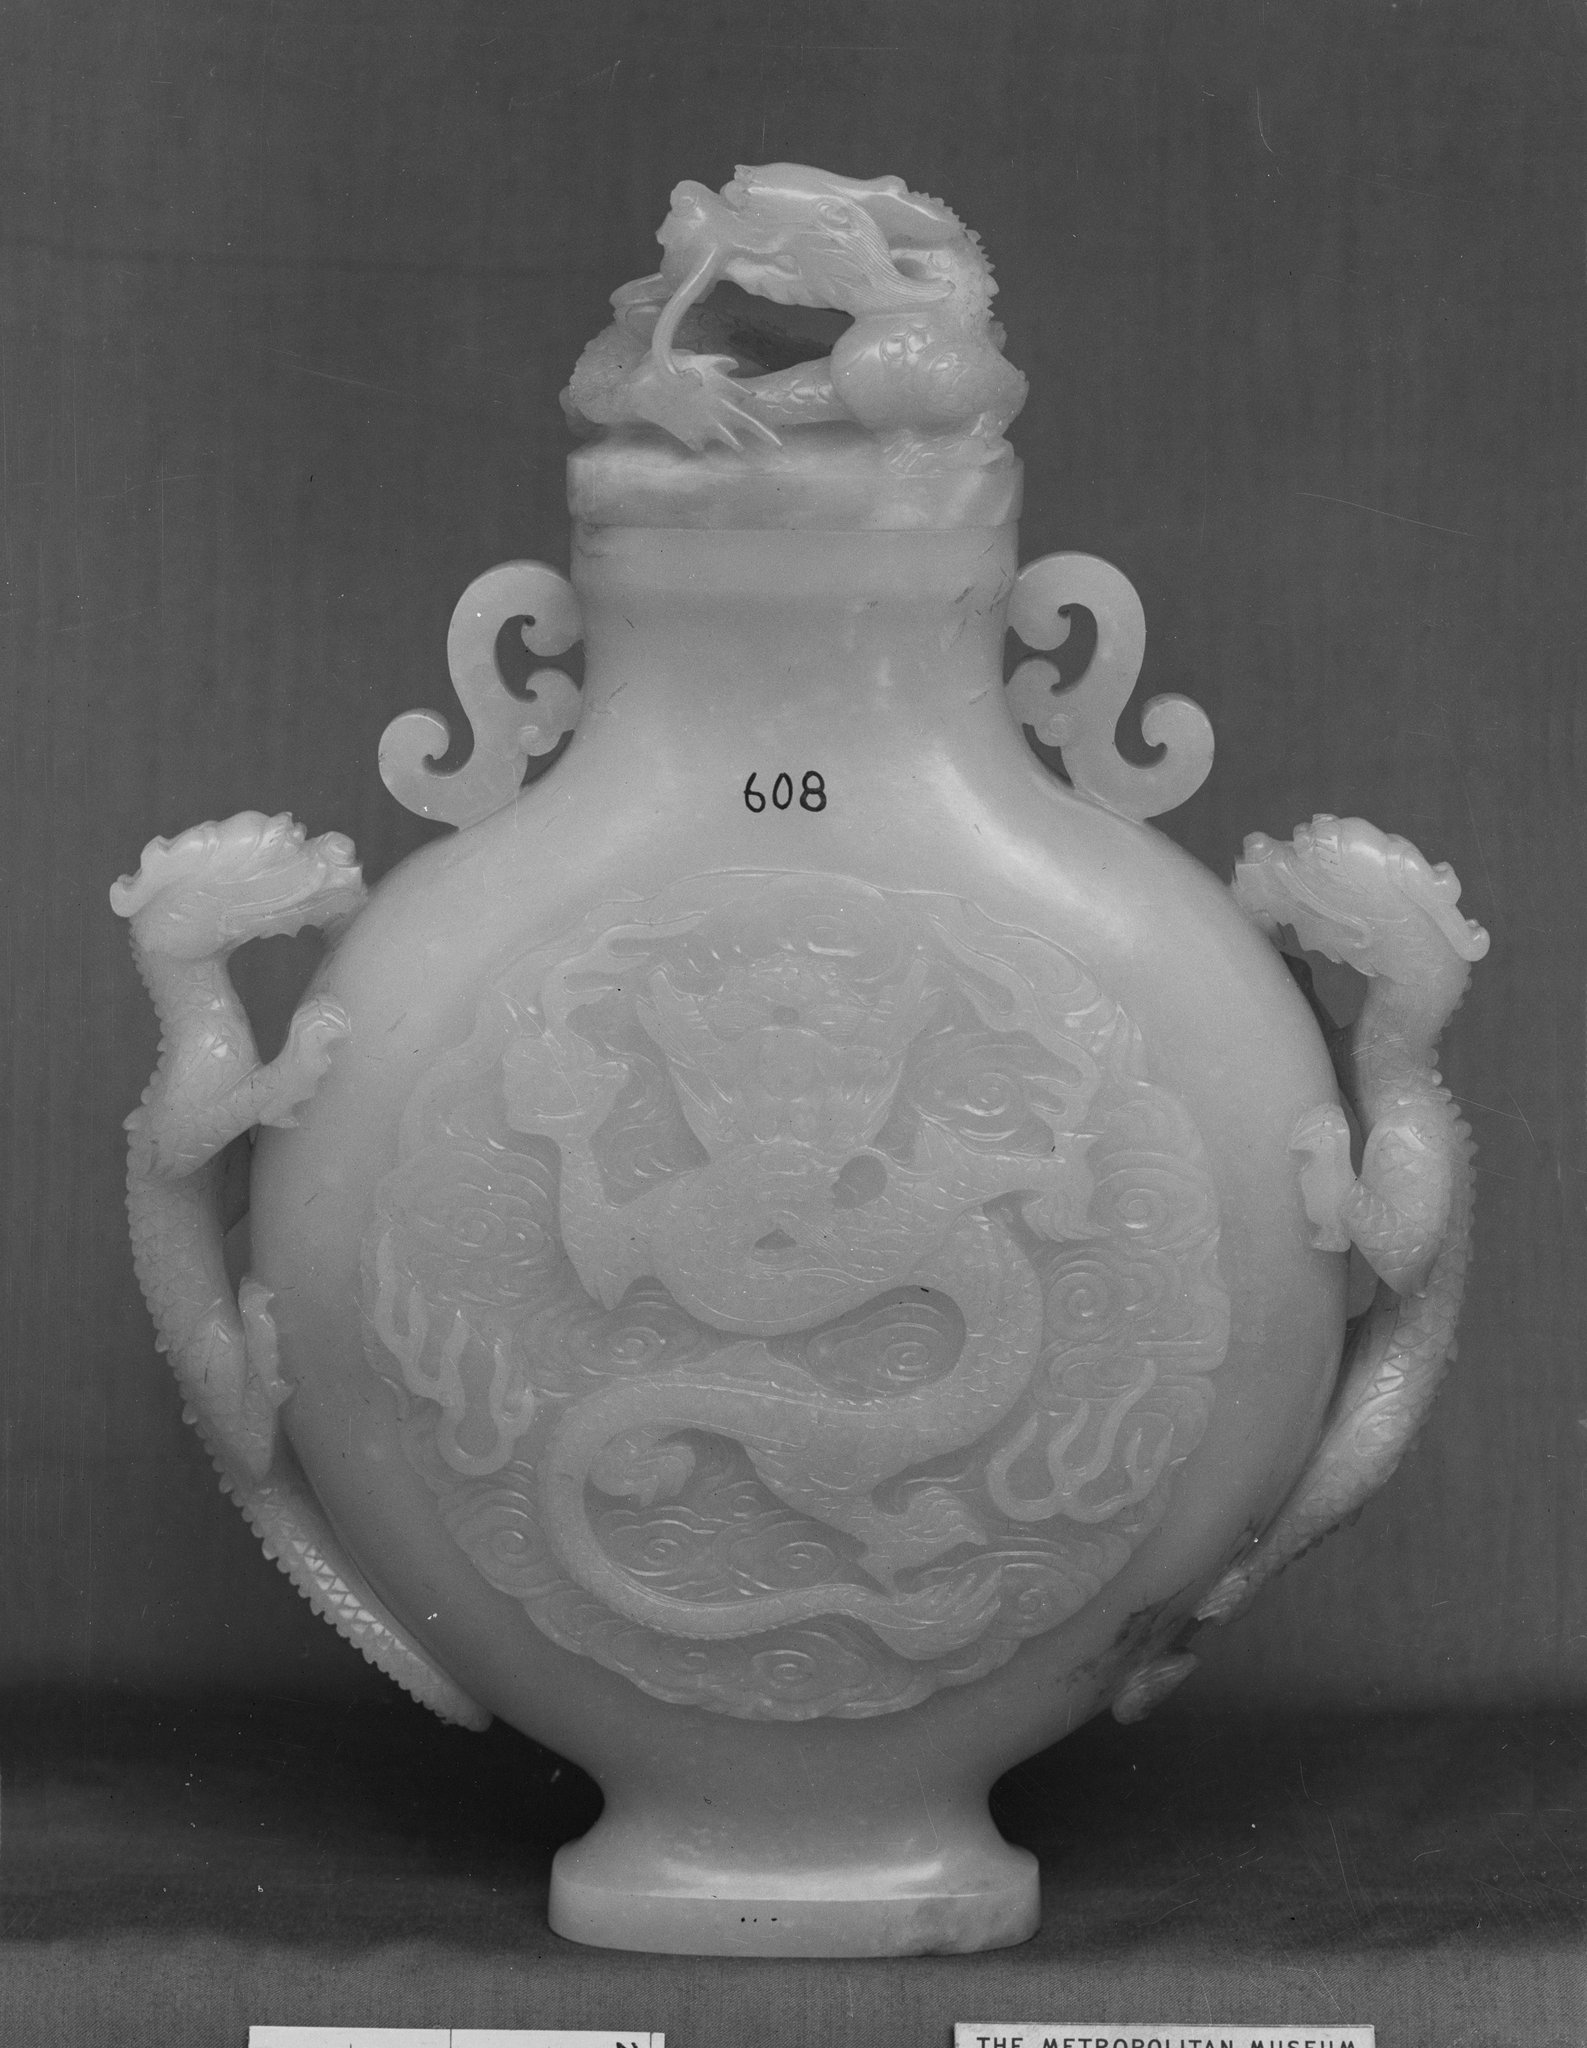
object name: pilgrim bottle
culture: chinese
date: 1736-1795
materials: jade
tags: dragons